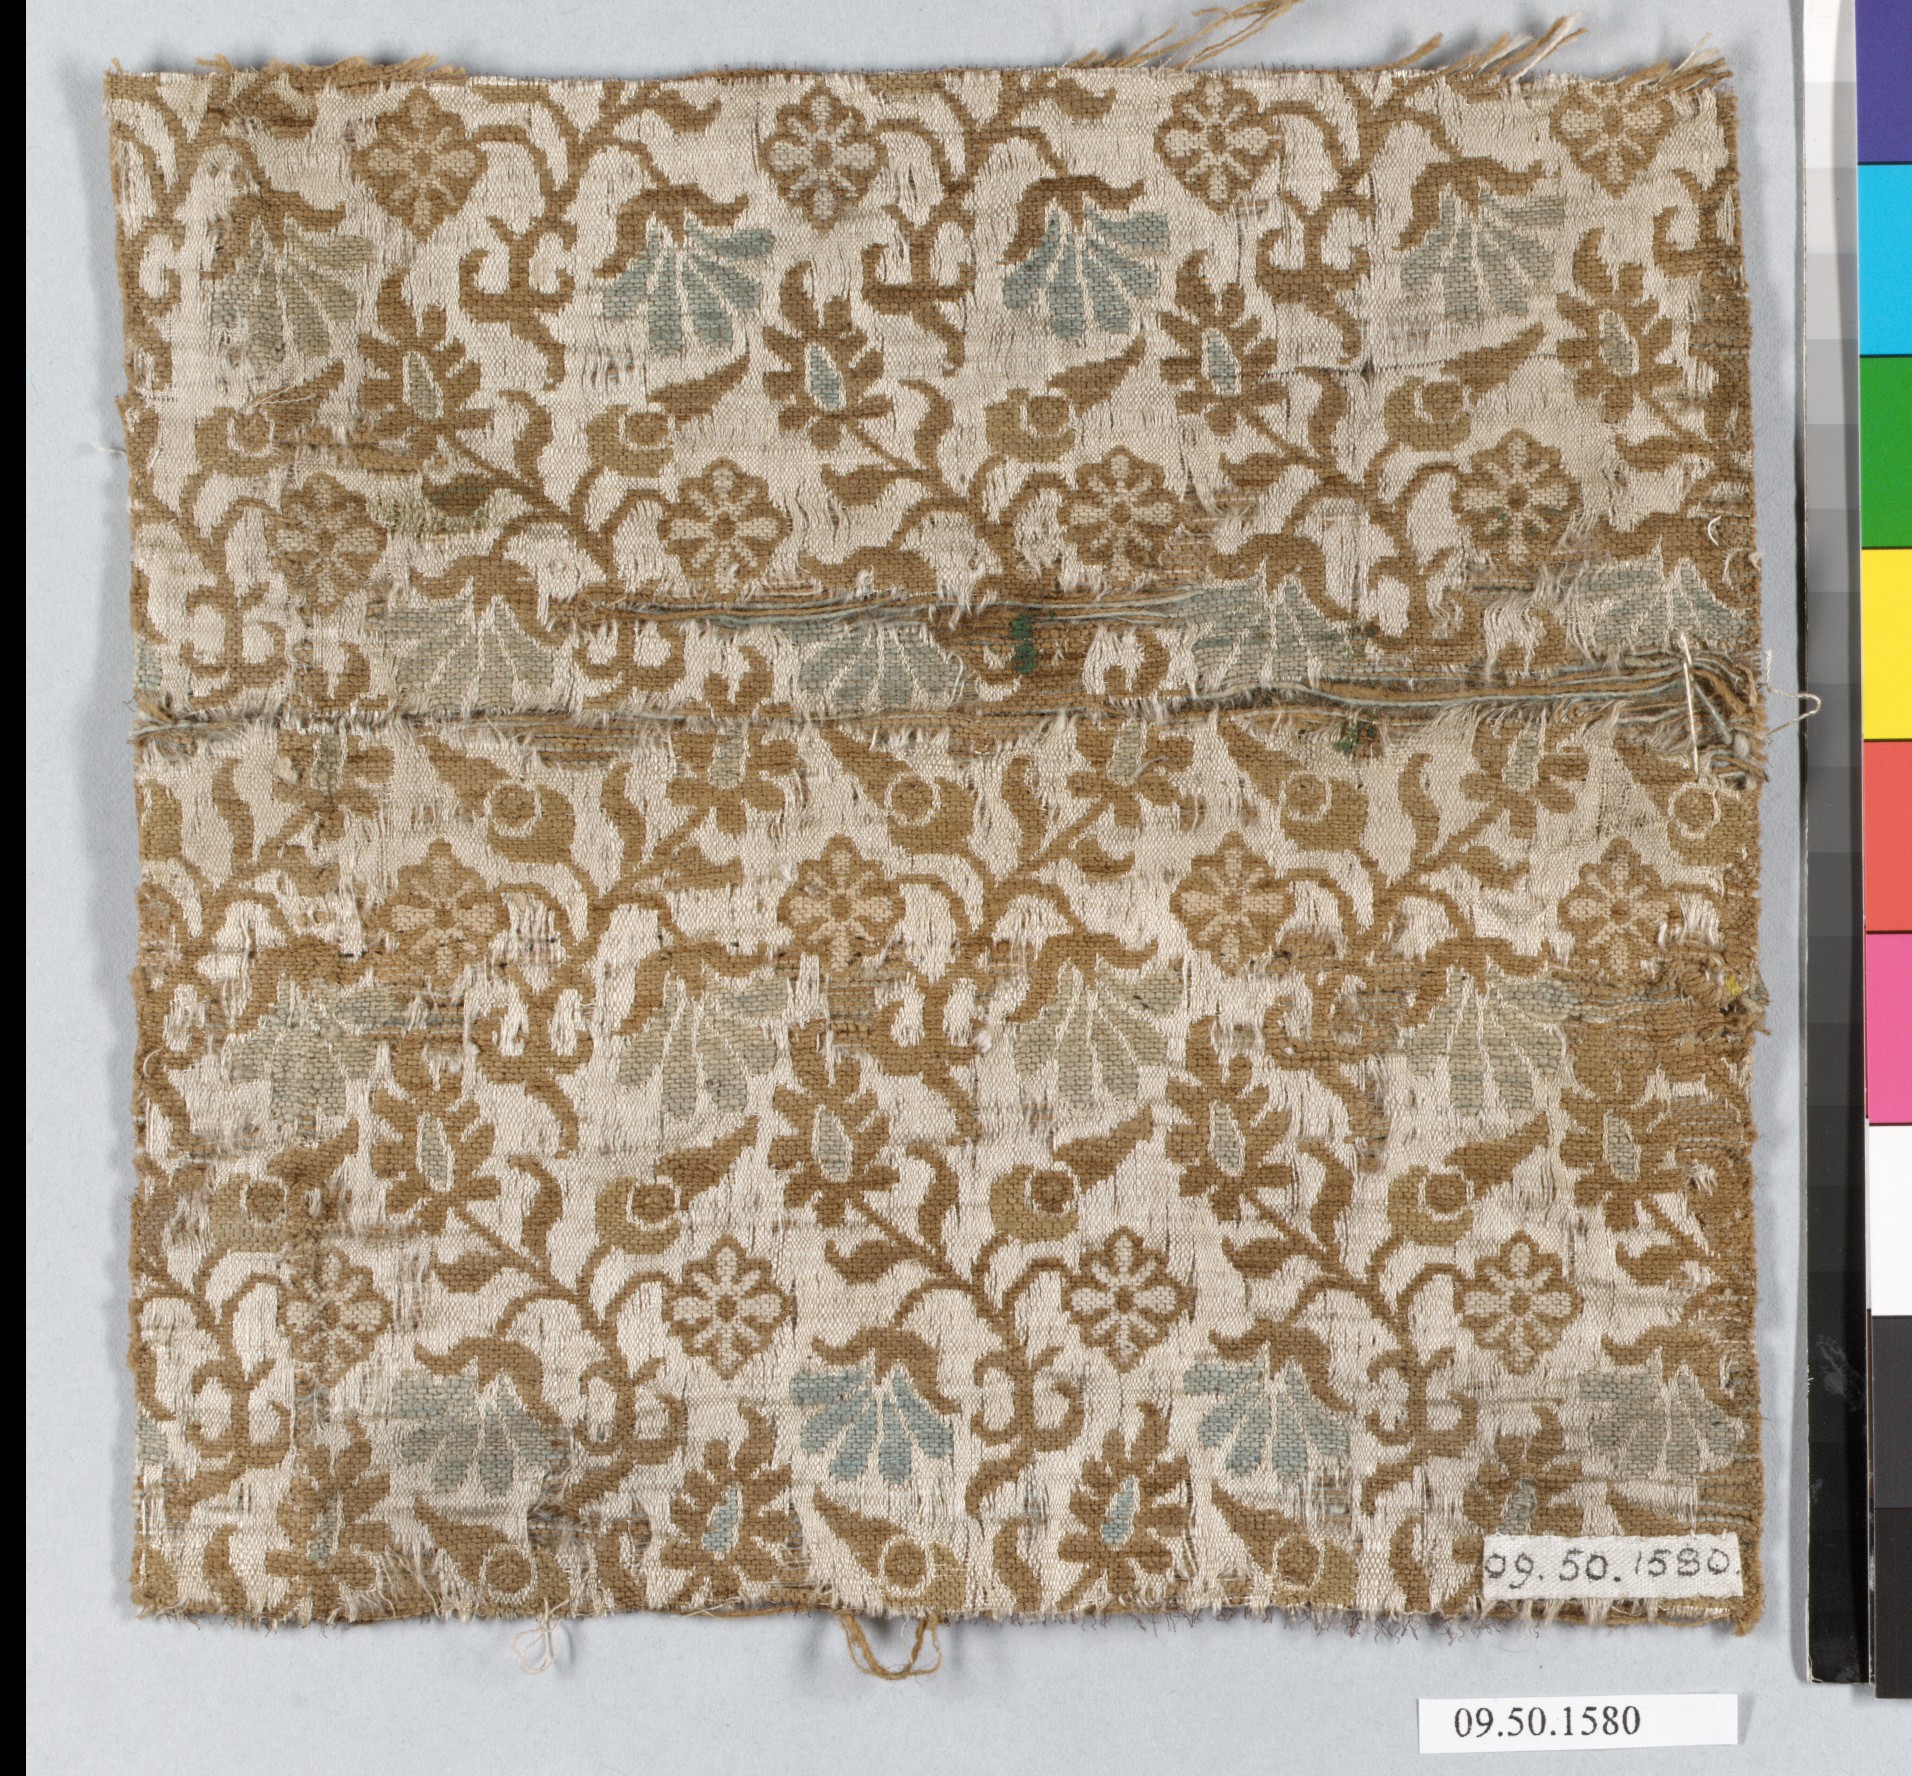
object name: fragment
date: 1801-1900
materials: cotton, silk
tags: flowers,leaves